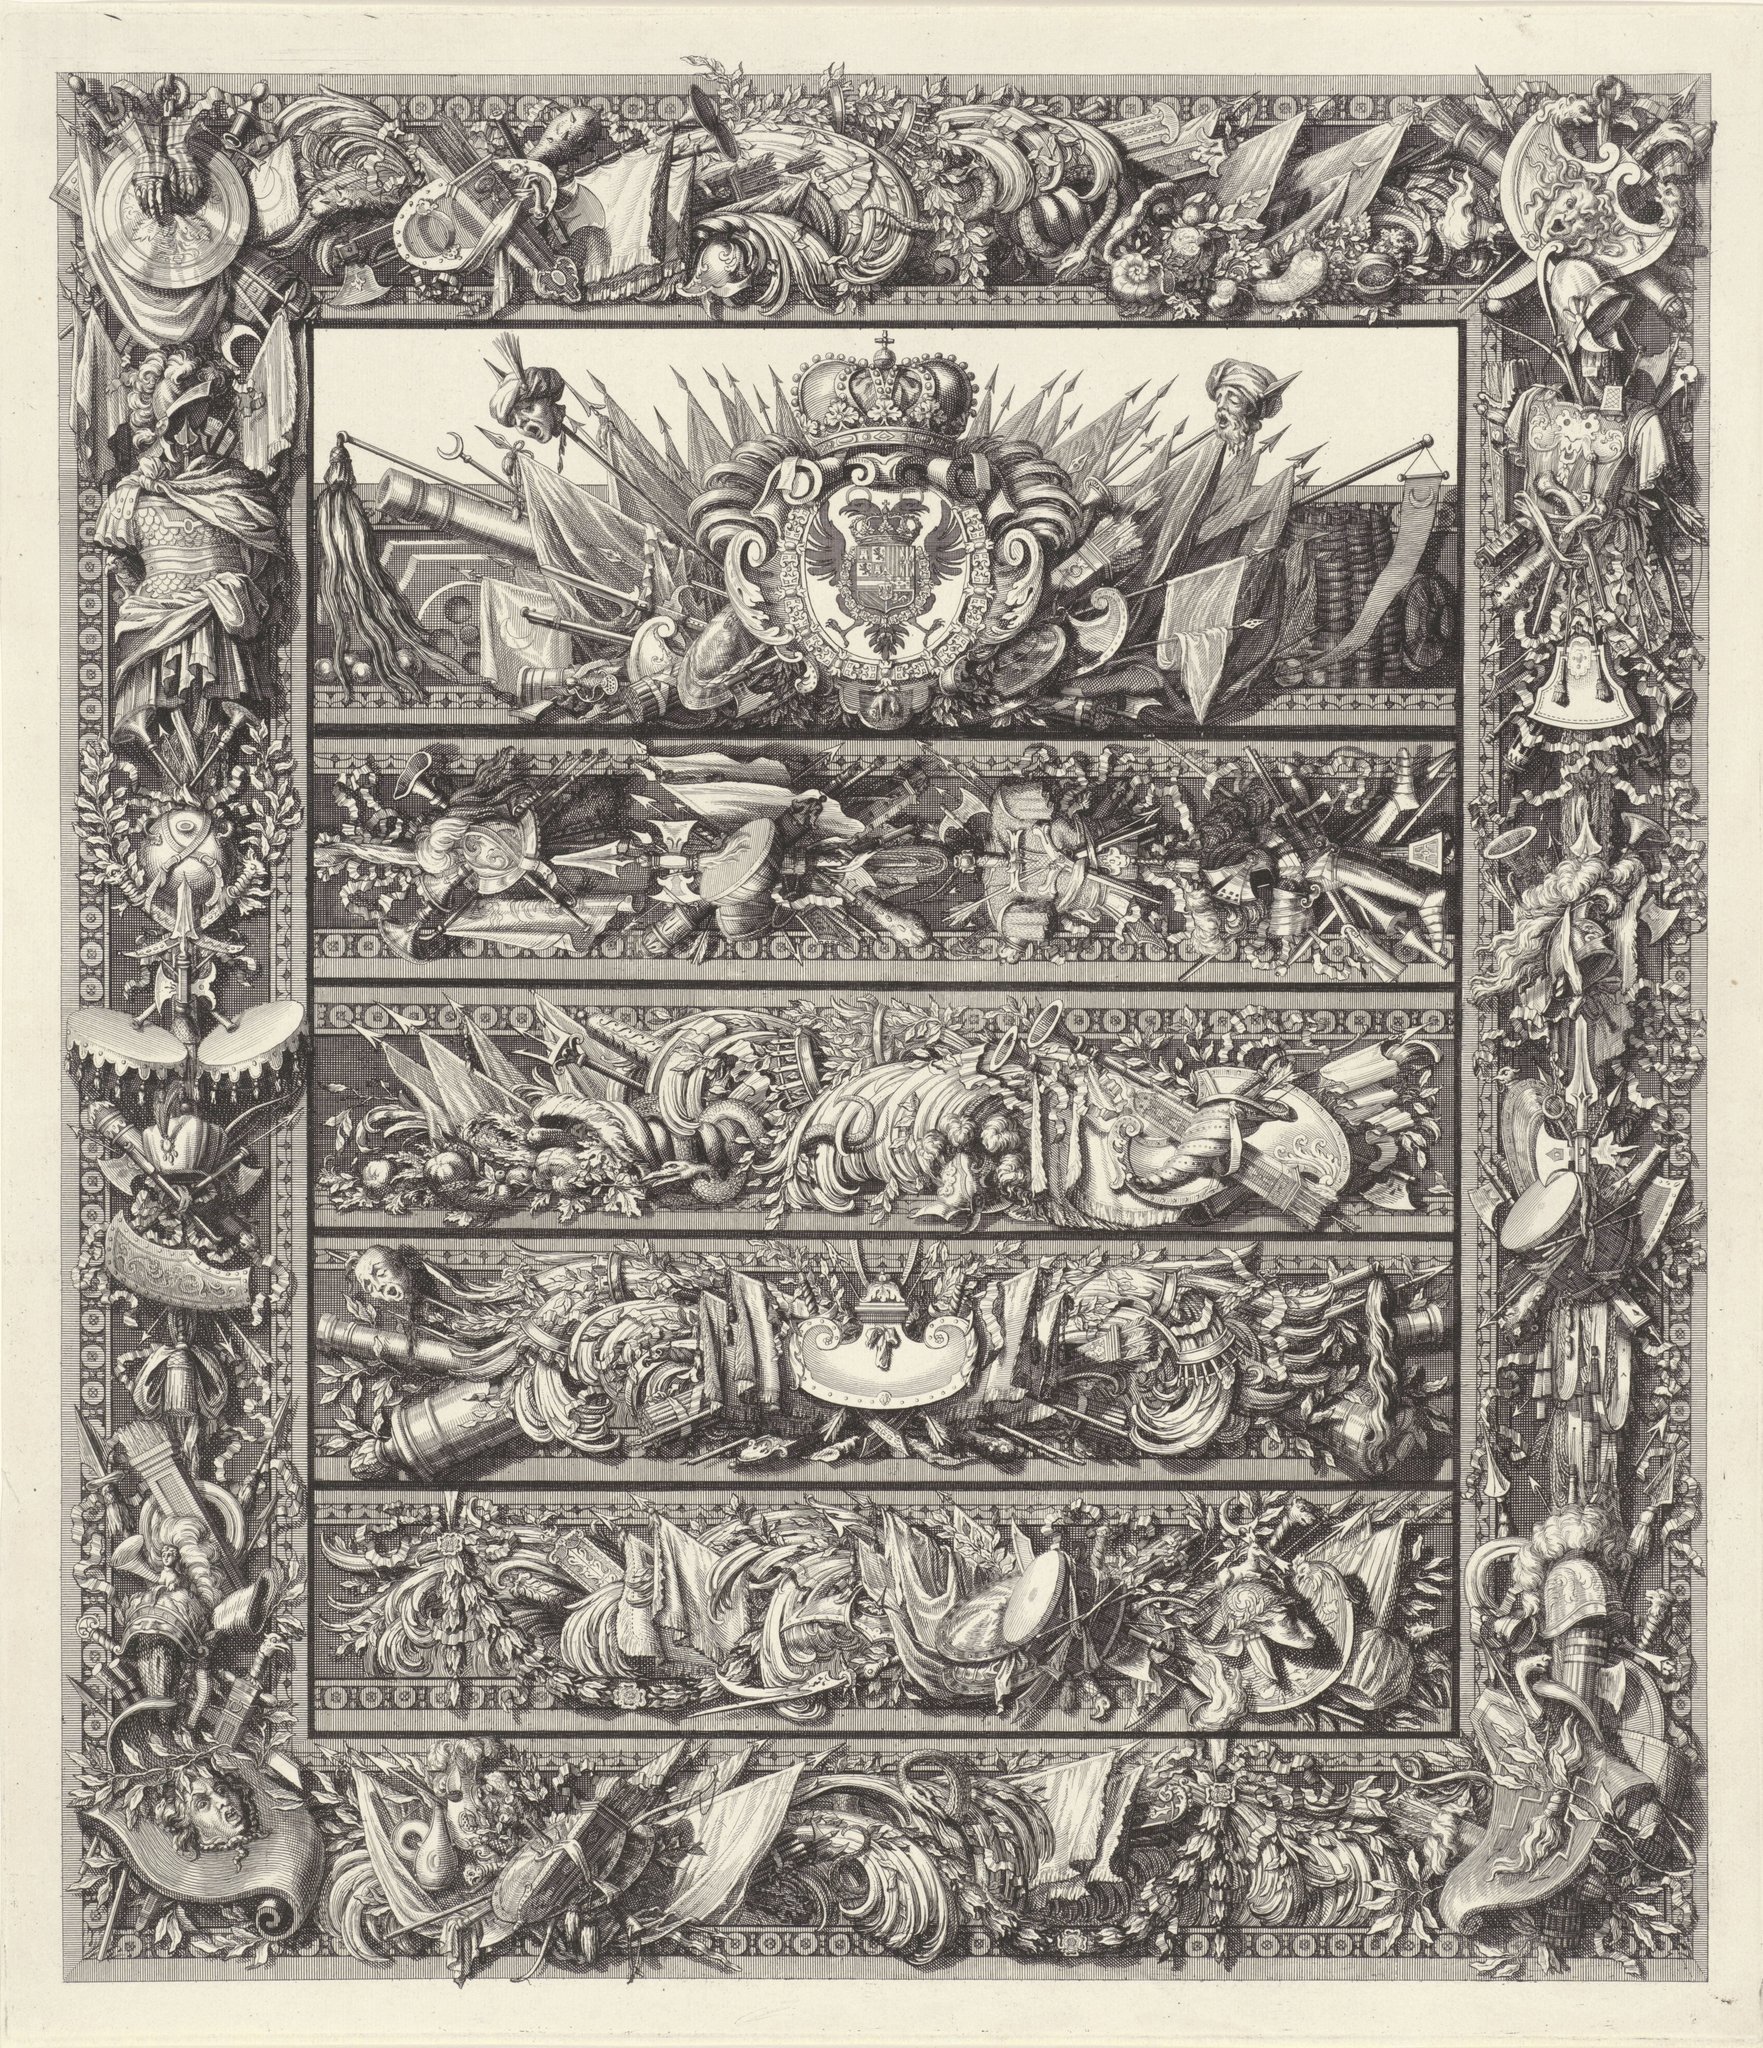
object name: print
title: Oorlogstrofeeën en het wapenschild van keizer Karel V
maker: Anonymous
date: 1683-1783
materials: paper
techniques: engraving, etching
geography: netherlands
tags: charles v (holy roman emperor and king of spain), coat of arms (as symbol of the state, etc.), ornaments ~ art, weapons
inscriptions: collector's mark: Lugt 2228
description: Vijf stroken met oorlogstrofeeën in een ornamentele lijst. In de bovenste strook het wapenschild van Karel V van Habsburg, Duits keizer en koning van Spanje. Rondom wapentuig en de gespieste hoofden van Ottomanen.